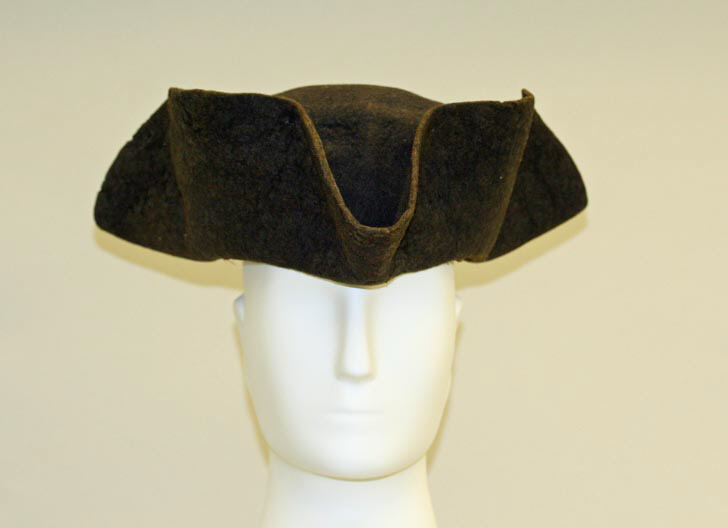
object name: tricorne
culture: american or european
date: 1701-1800